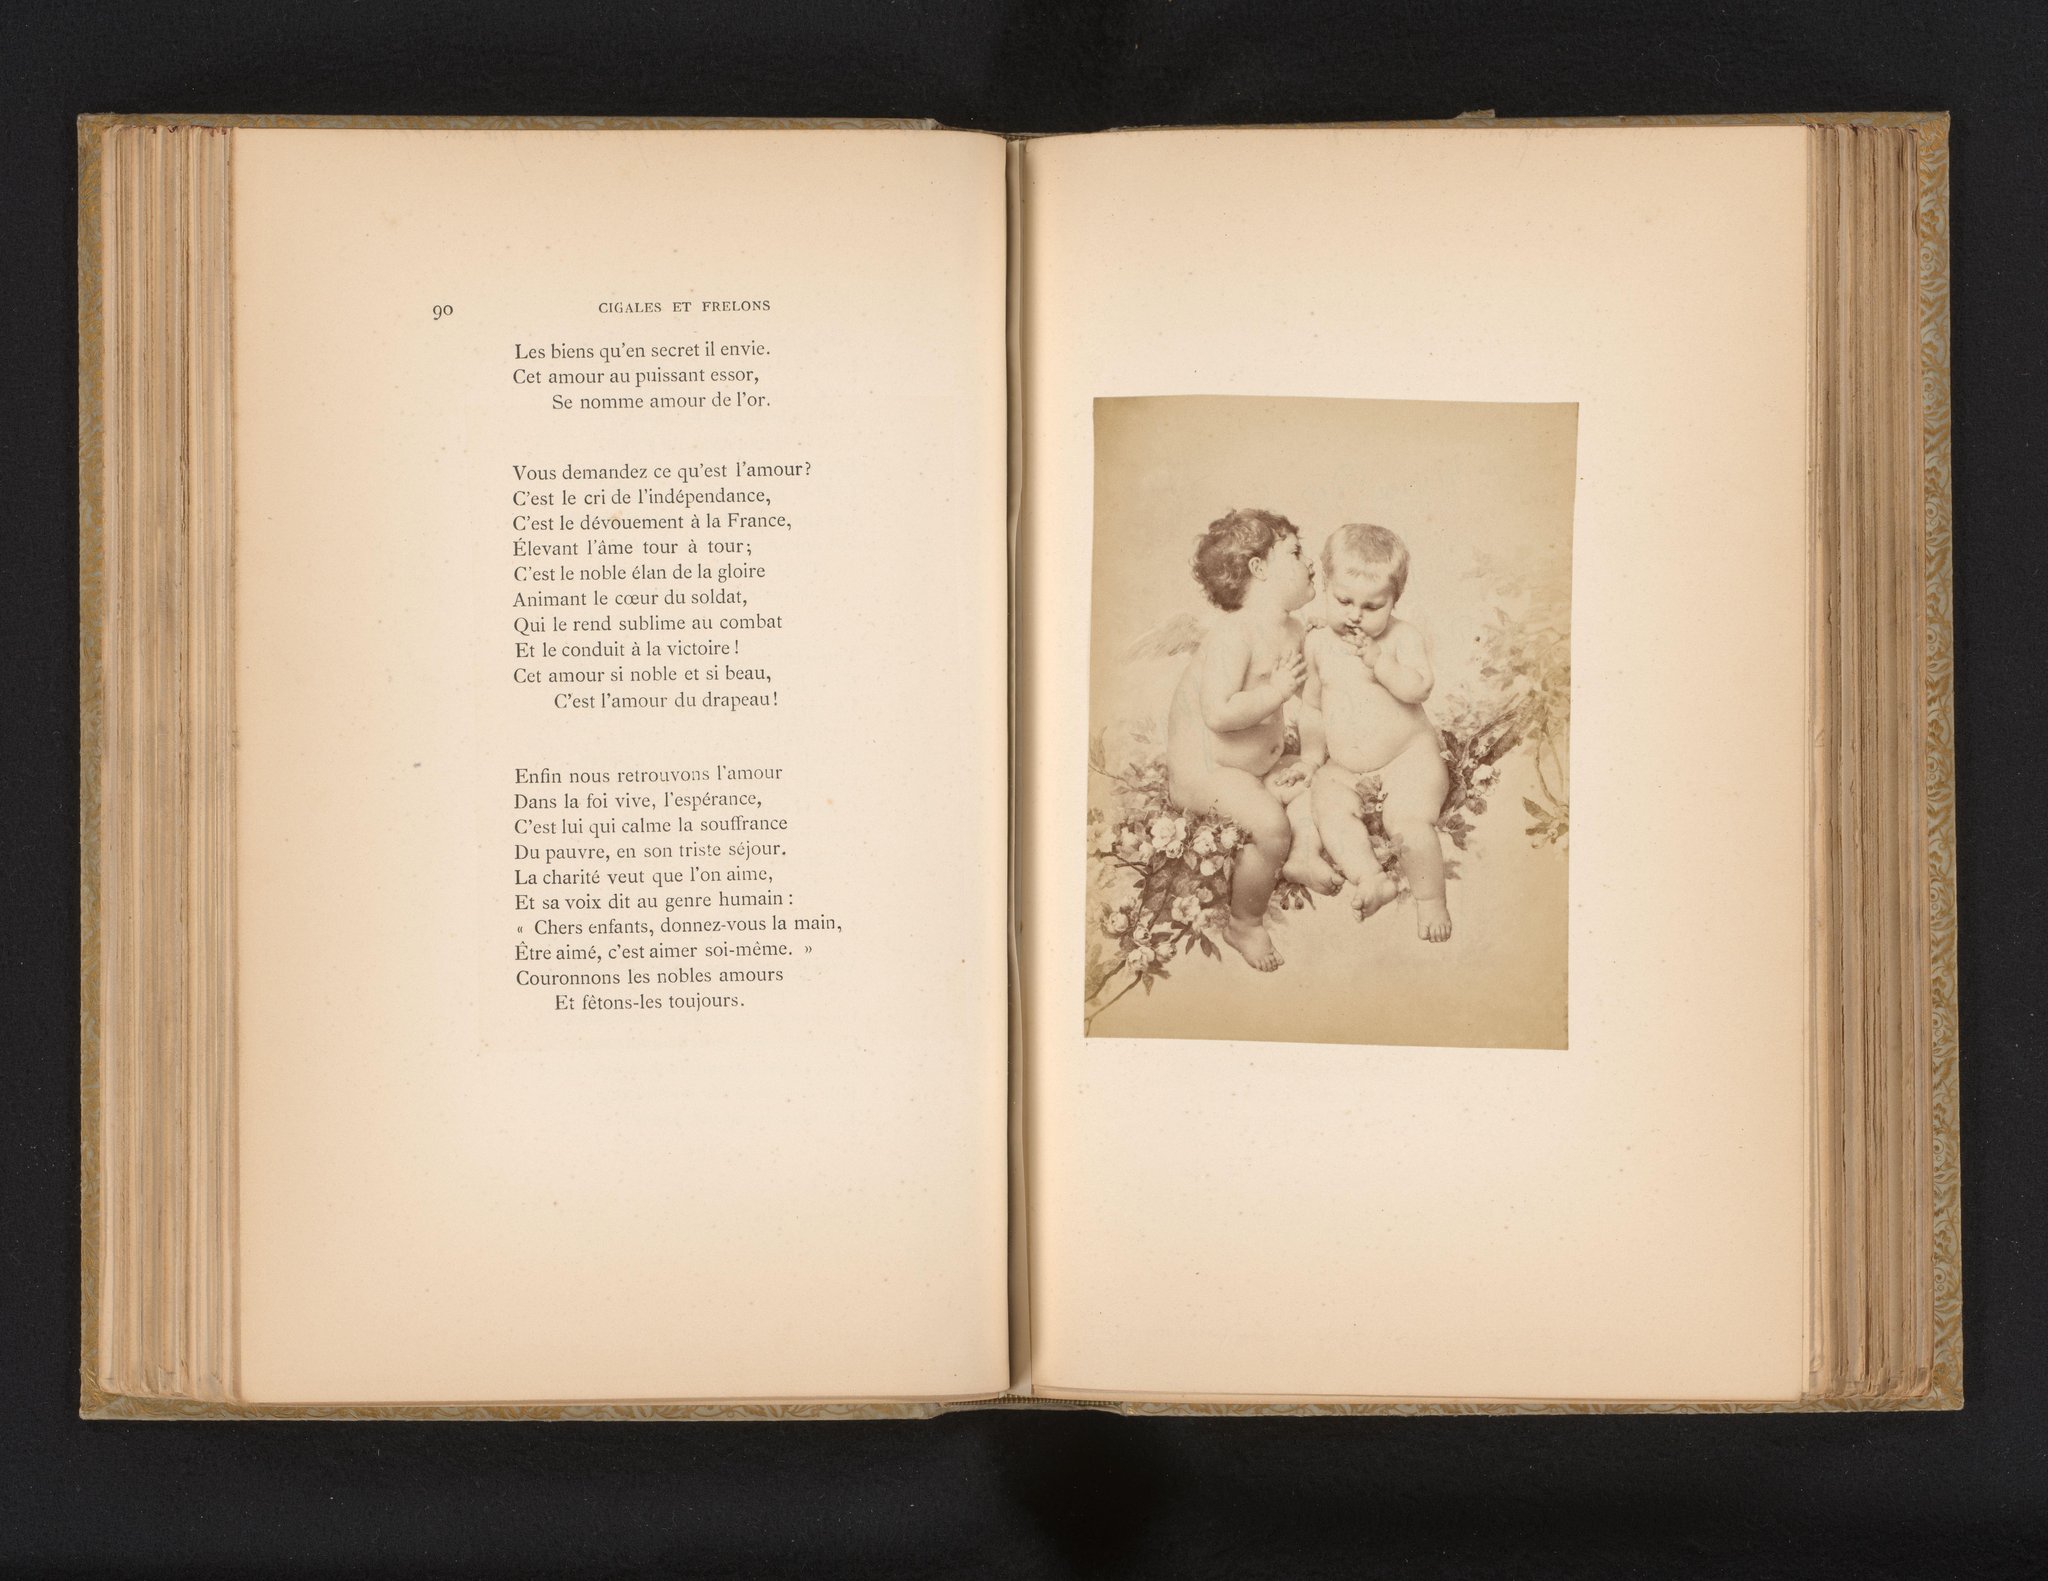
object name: reproduction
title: Fotoreproductie van een schilderij van twee putti in boomtak met bloesem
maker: Anonymous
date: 1874-1884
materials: paper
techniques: albumen print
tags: trees, picture, painting, cupids: 'amores', 'amoretti', 'putti'